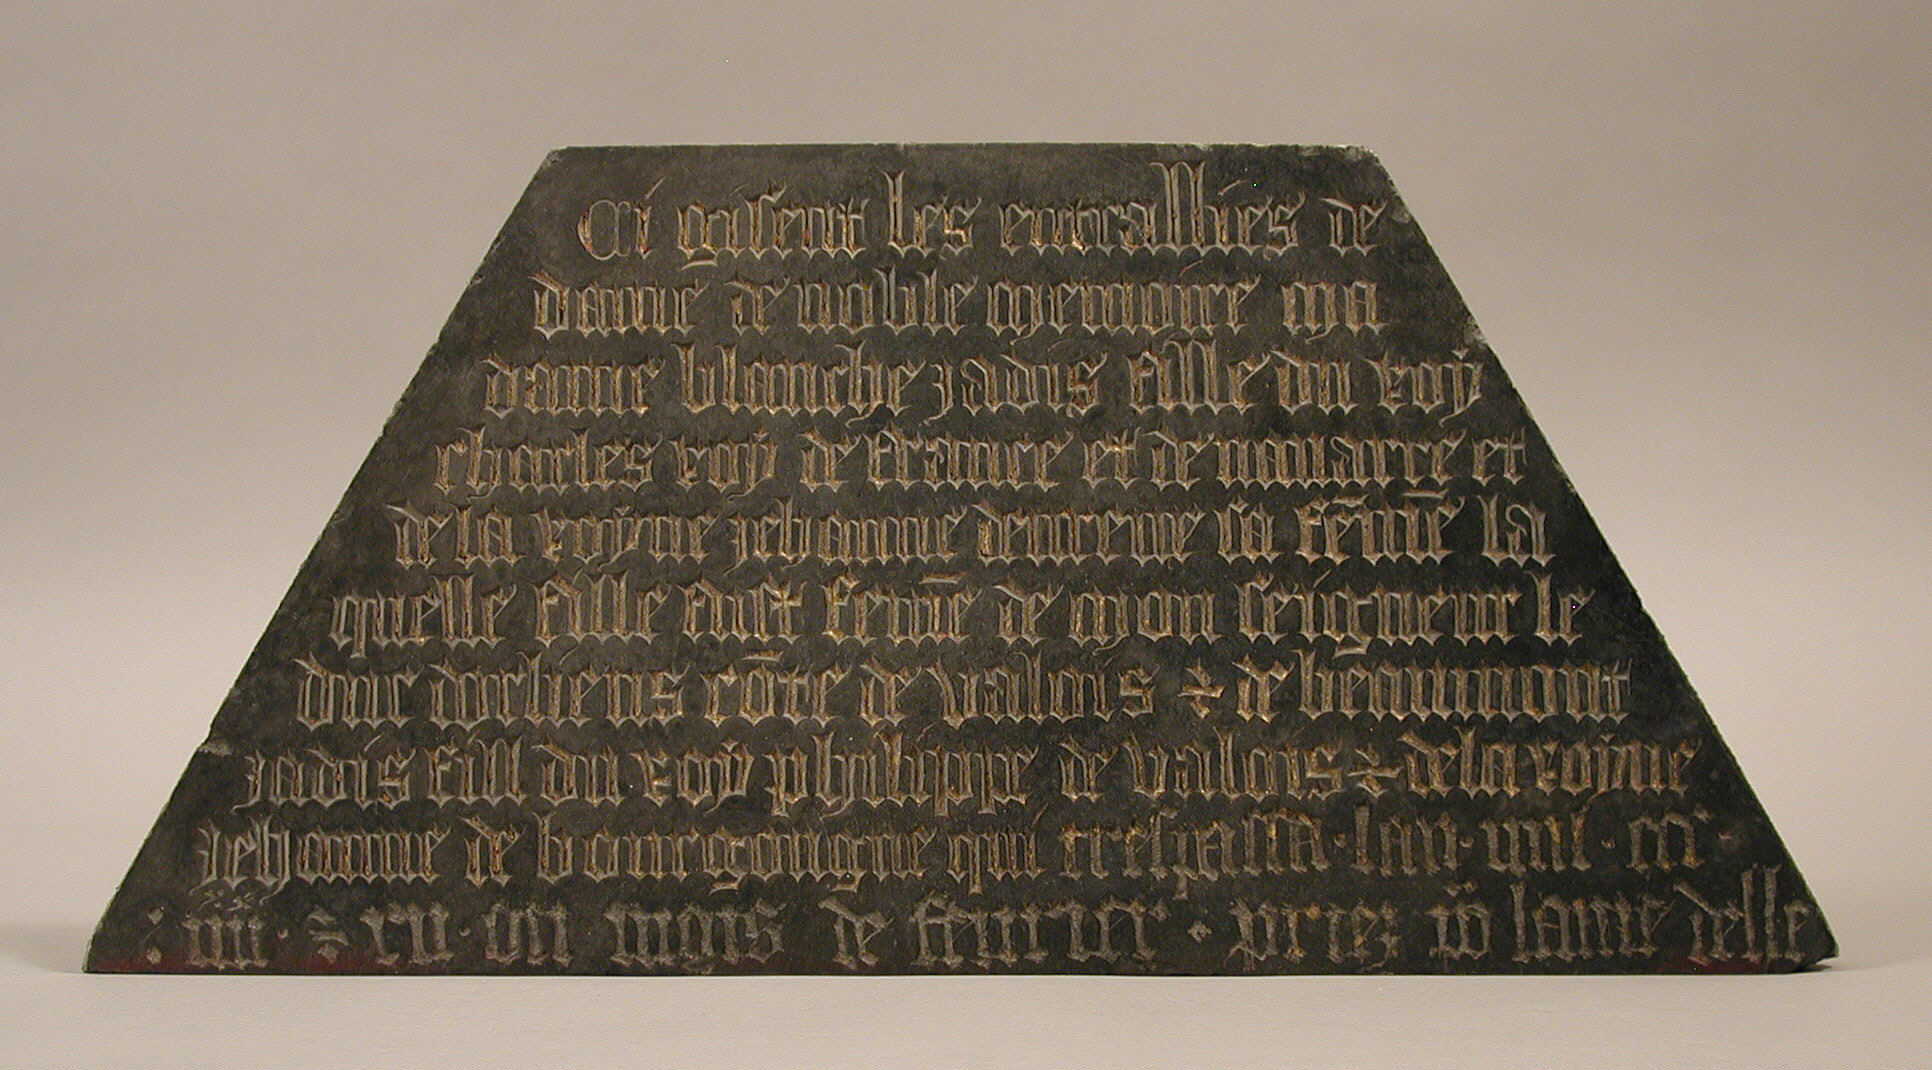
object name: tomb plaque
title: Tomb Plaque of Blanche of France (1328–92), daughter of Charles IV of France and Jeanne d'Evreux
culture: french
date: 1392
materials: marble, paint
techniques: gilding